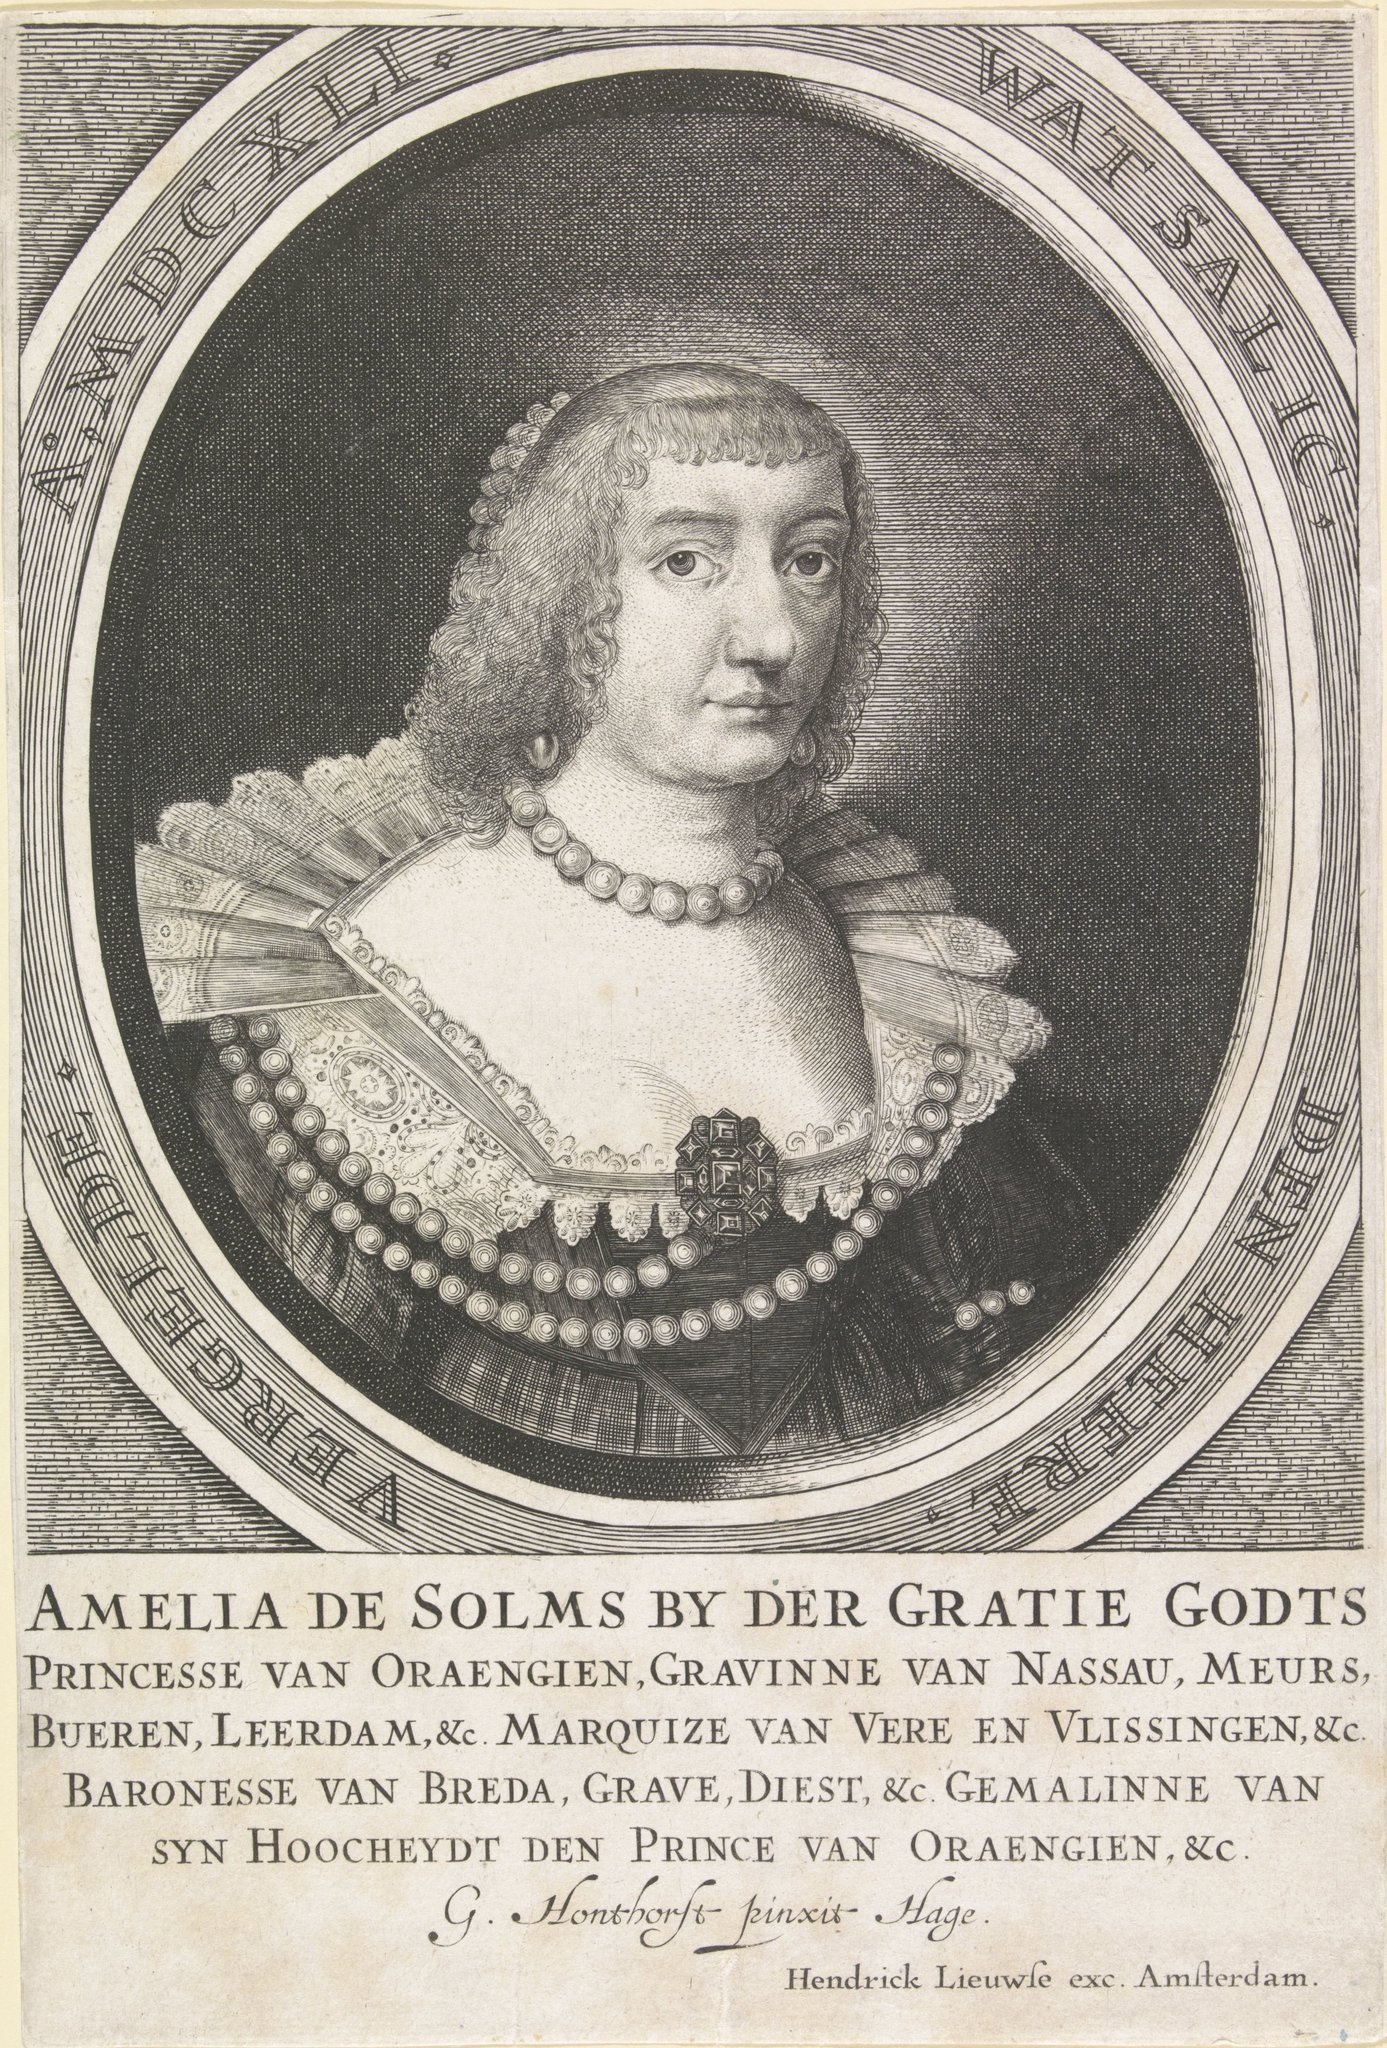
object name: print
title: Portret van Amalia van Solms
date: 1641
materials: paper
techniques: engraving, etching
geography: low countries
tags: the hague, amalia of solms-braunfels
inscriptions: date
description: Portret van Amalia in een ovaal met randschrift. In de ondermarge haar naam.